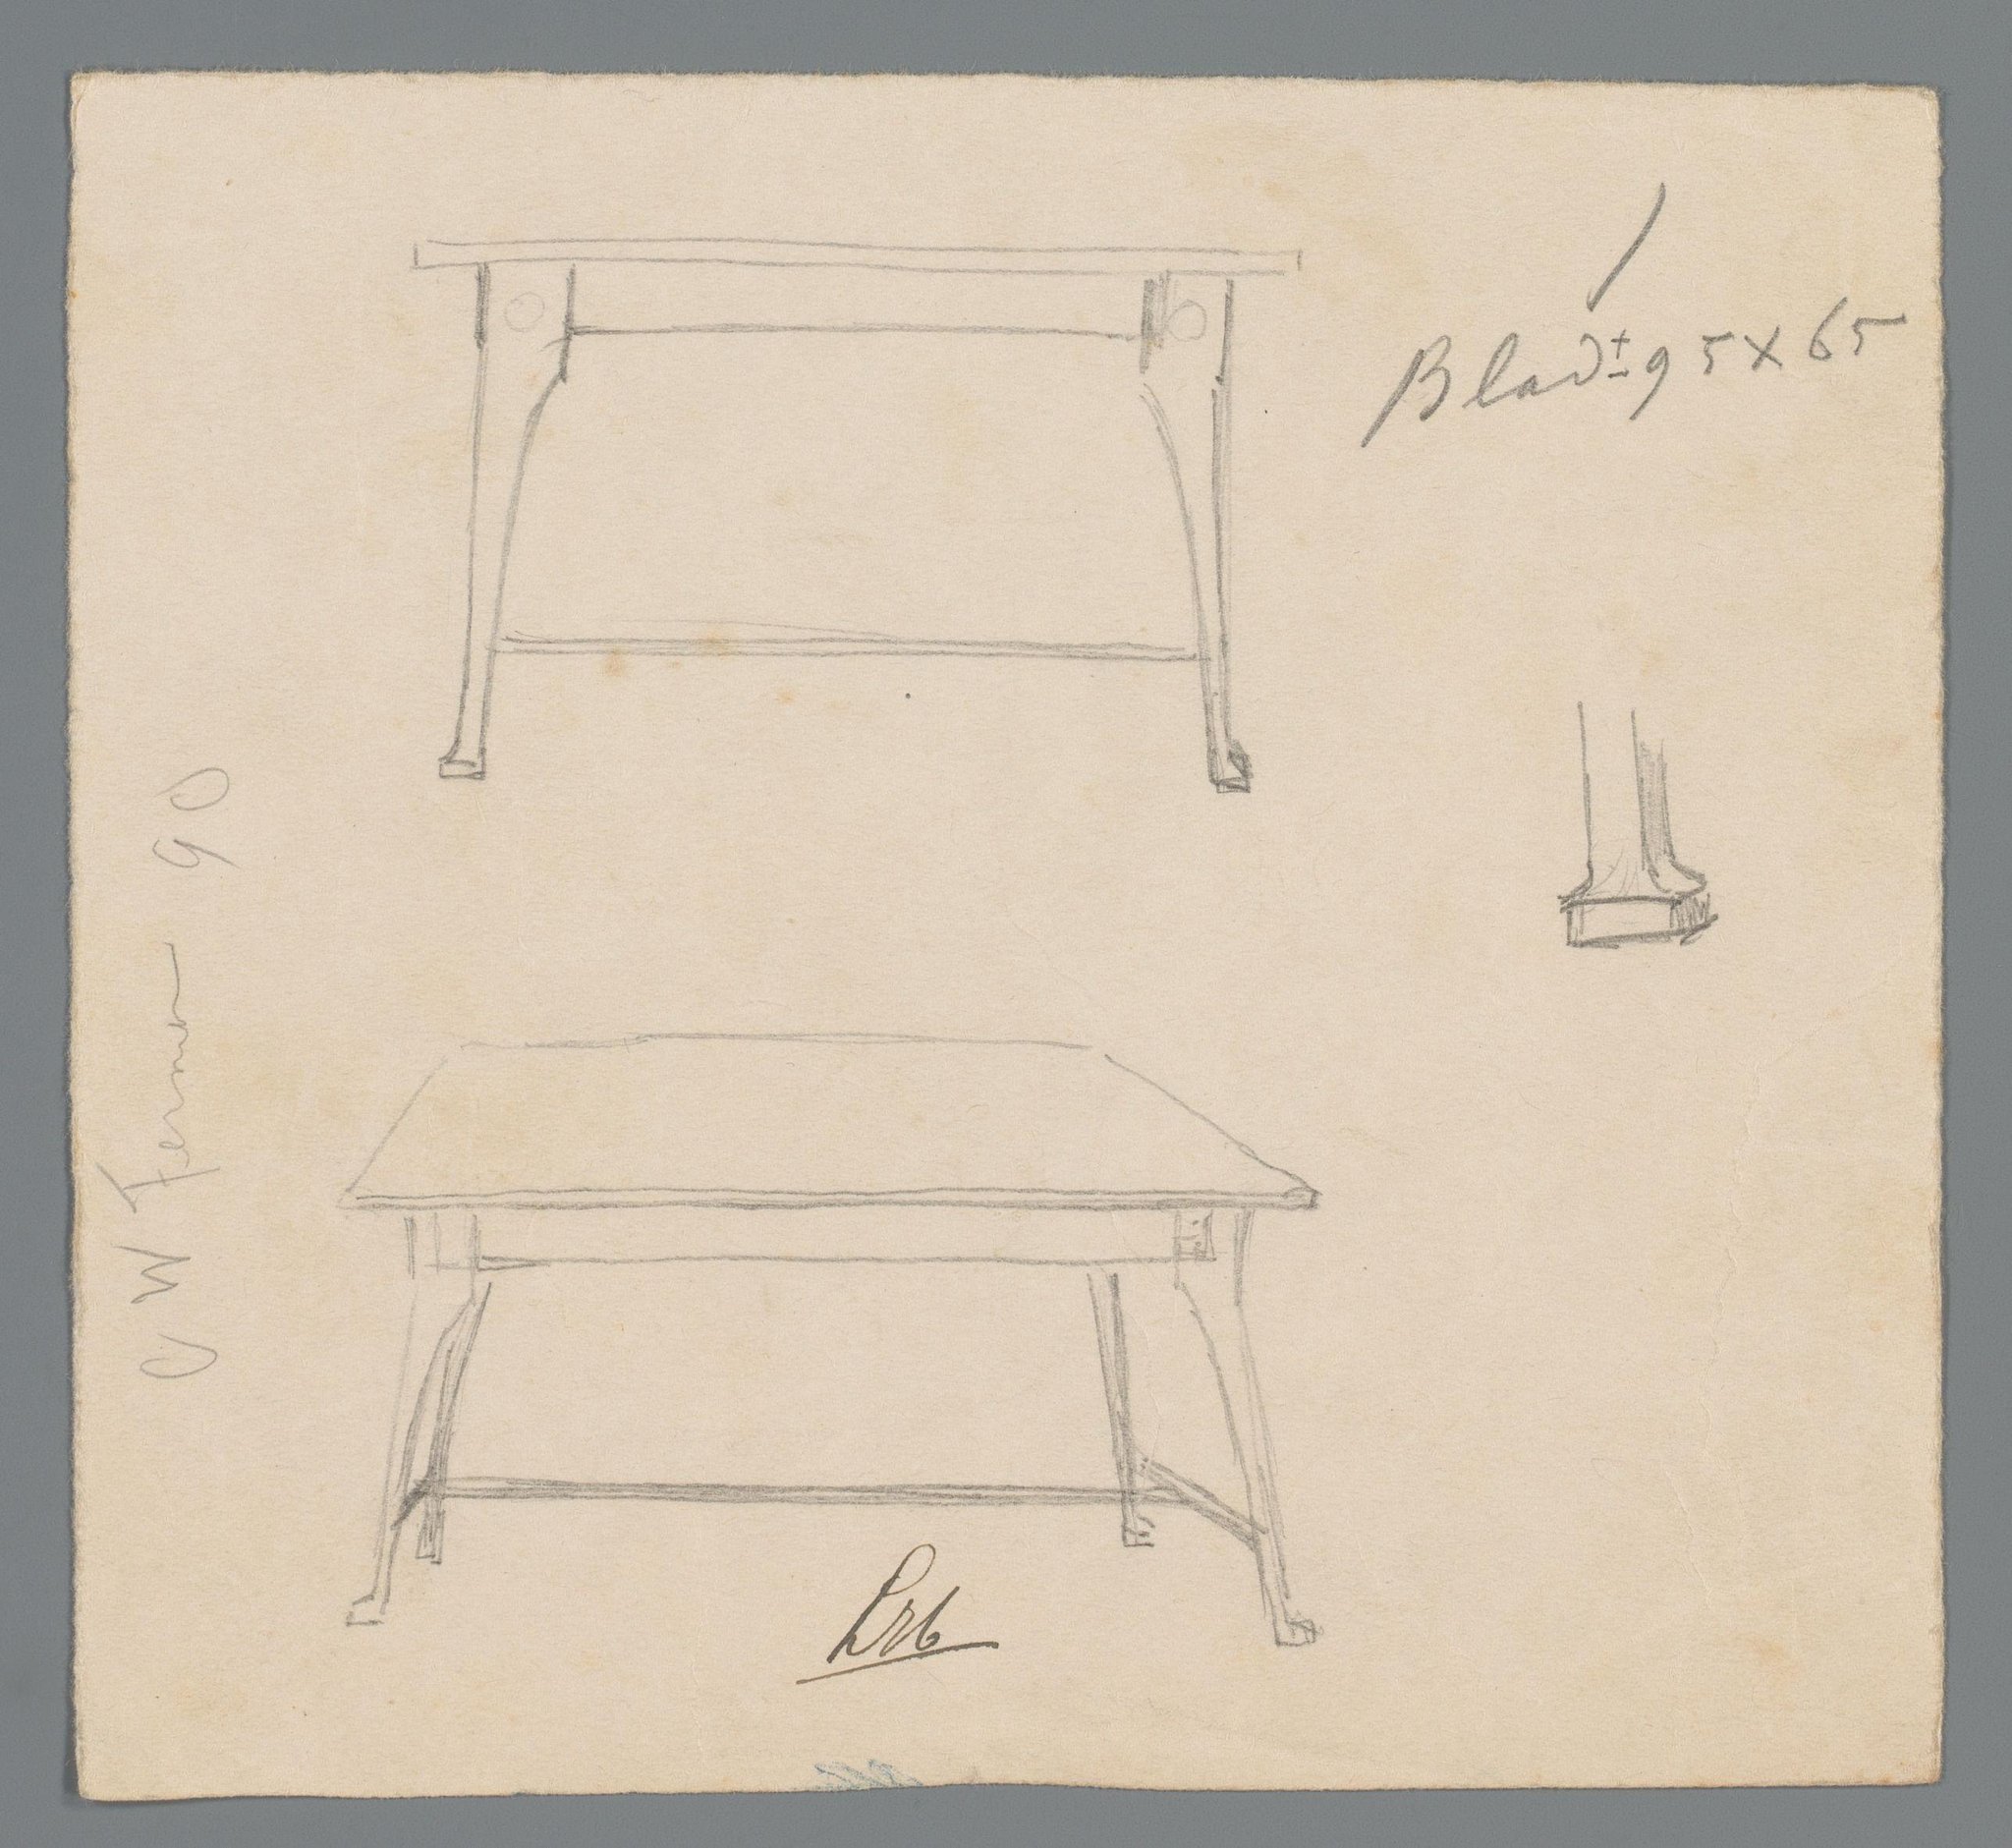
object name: design drawing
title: Ontwerp voor een tafel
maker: gust van de wall perné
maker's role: draughtsman, painter, print maker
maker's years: 1877-1911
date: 1887-1911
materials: paper, pencil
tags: table